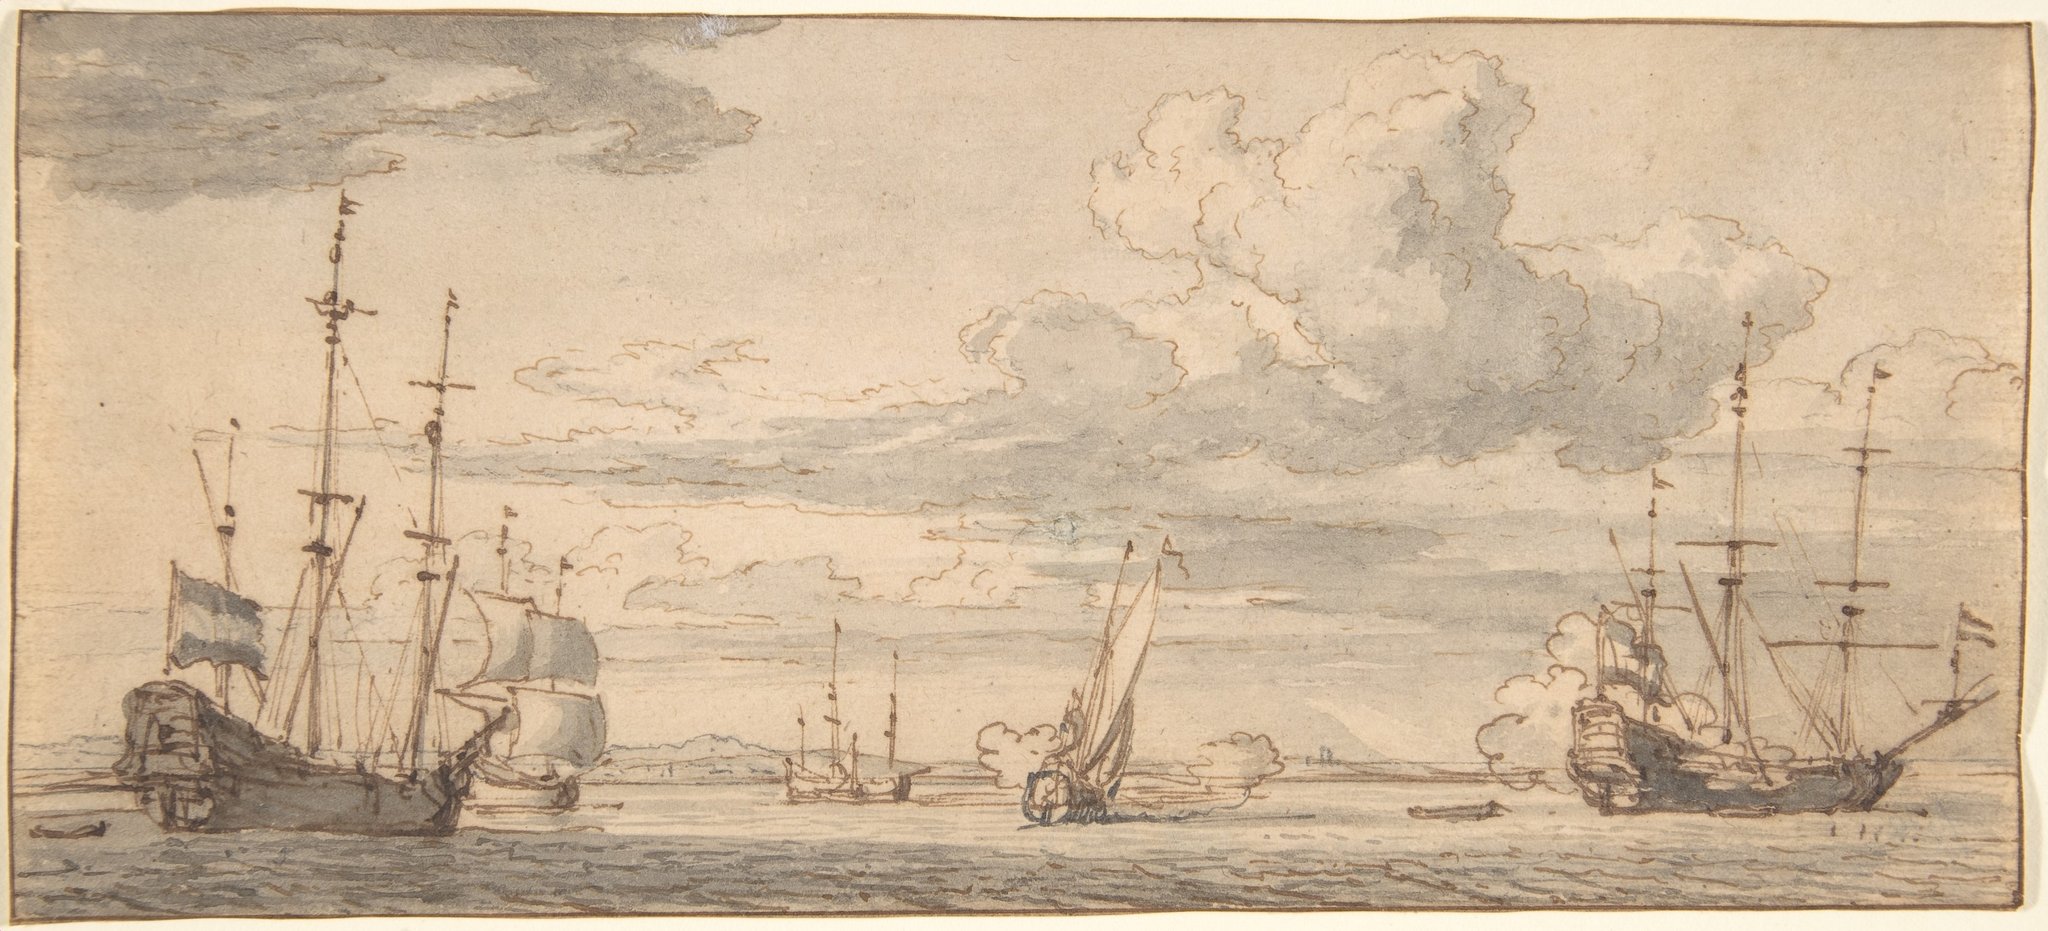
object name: drawing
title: Dutch Ships in a Bay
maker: willem van de velde (ii)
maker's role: artist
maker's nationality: dutch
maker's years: 1633-1707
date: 1634-1733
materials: chalk, ink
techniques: brush, pen, wash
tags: ships